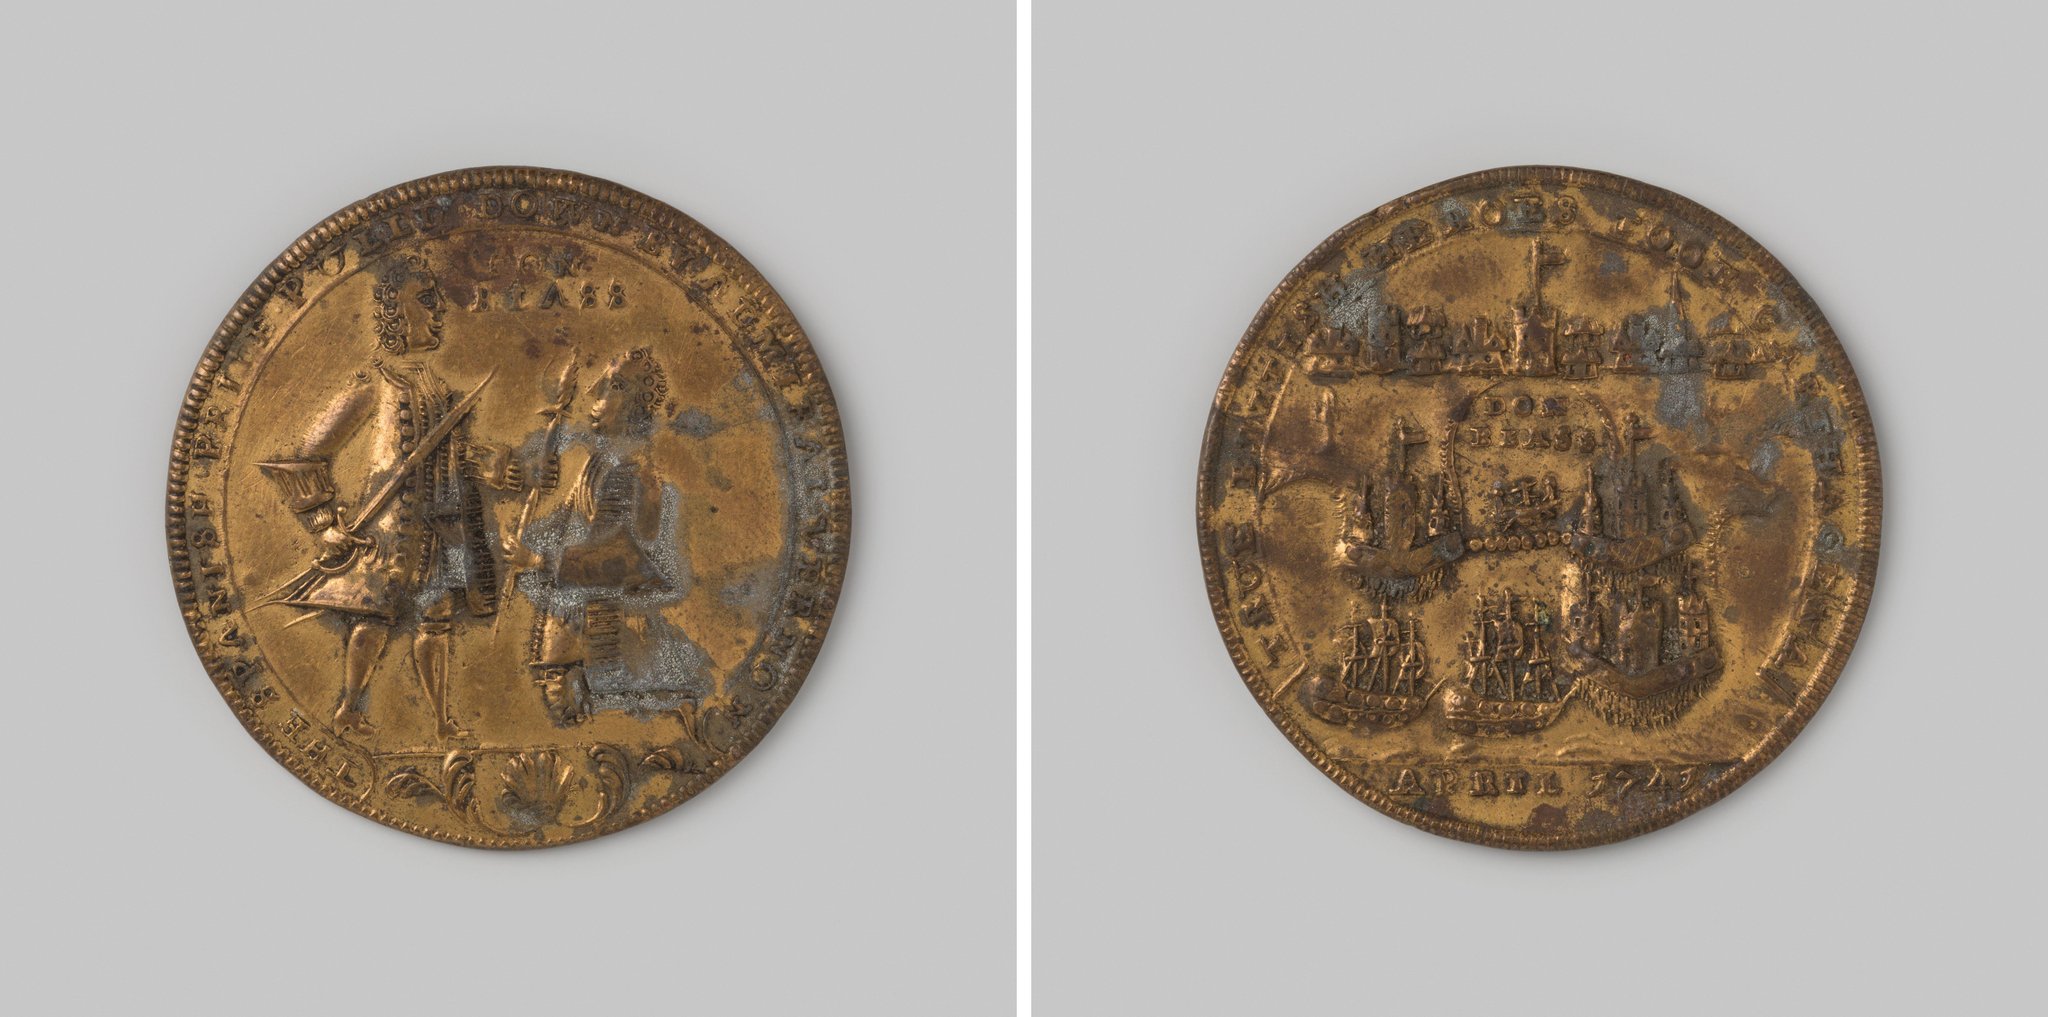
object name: history medal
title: Inname van Carthagena door Admiraal Vernon 1741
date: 1741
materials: brass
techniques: striking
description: Messing penning, op de voorzijde Vernon staand met zwaard, ontvangt het zwaard van de Spaanse verdediger Blas, met omschrift, op de keerzijde de vloot voor de haven van Cartagena met zijn kastelen, met omschrift en afsnedetekst.